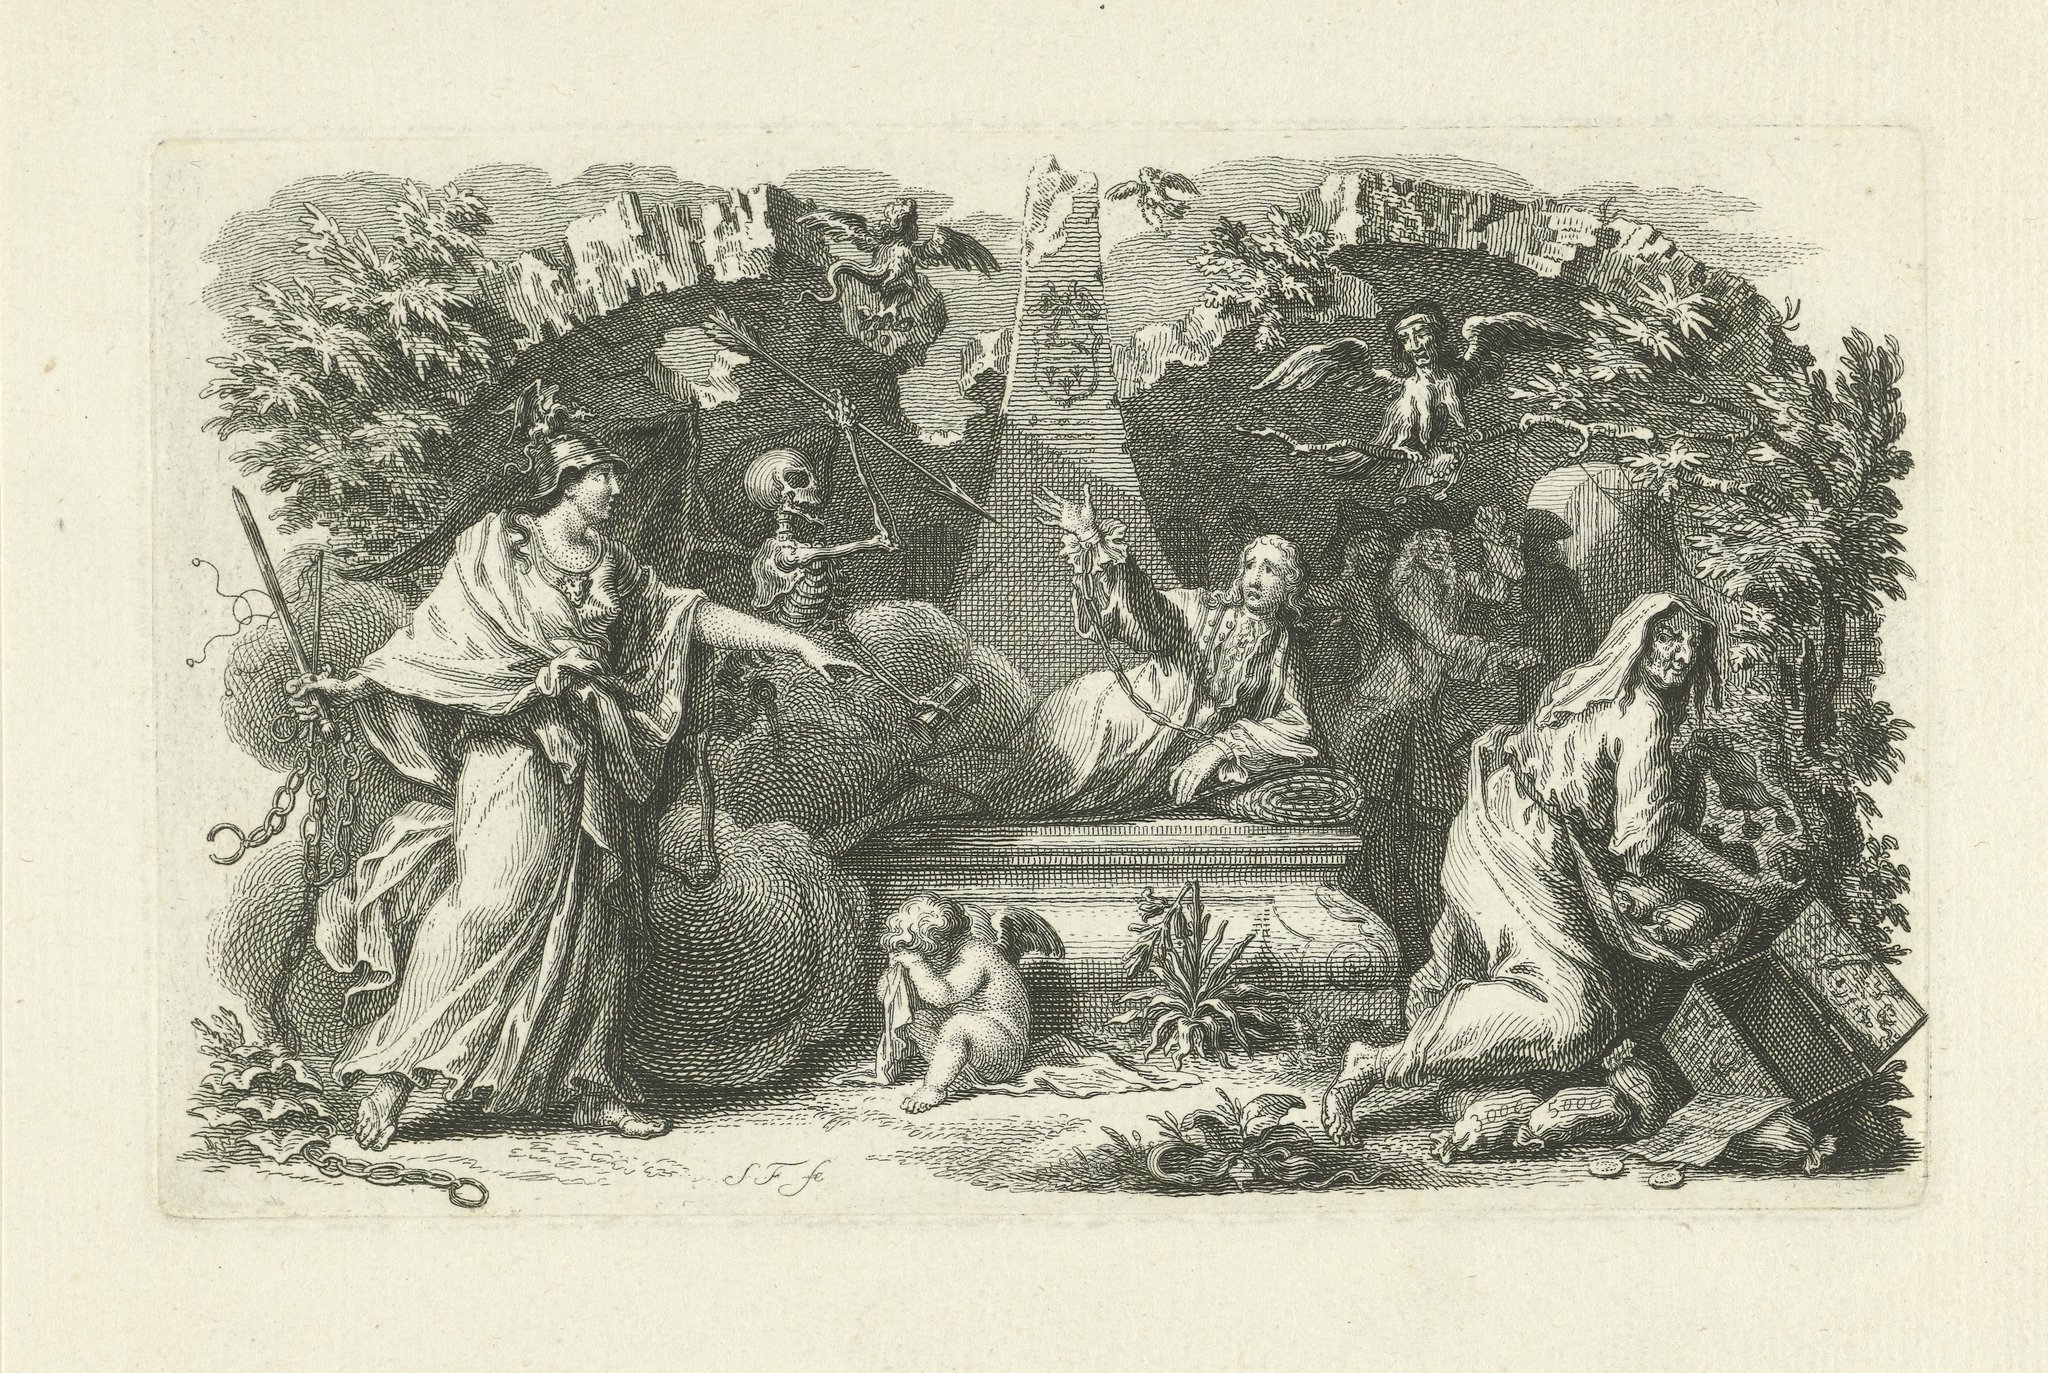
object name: print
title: Allegorische voorstelling met graftombe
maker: simon fokke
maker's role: draughtsman, print maker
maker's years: 1712-1784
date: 1722-1784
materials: paper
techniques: engraving, etching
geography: amsterdam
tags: devils in the form of (fabulous) animals, death as skeleton, grave, tomb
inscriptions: collector's mark: Lugt 2228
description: Allegorische voorstelling met verschillende personificaties rond een graftombe. Een skelet probeert de op de tombe liggende man met een speer te raken. In de lucht vliegen duivelse figuren. Aan de voet van de graftombe zit een putto te huilen.